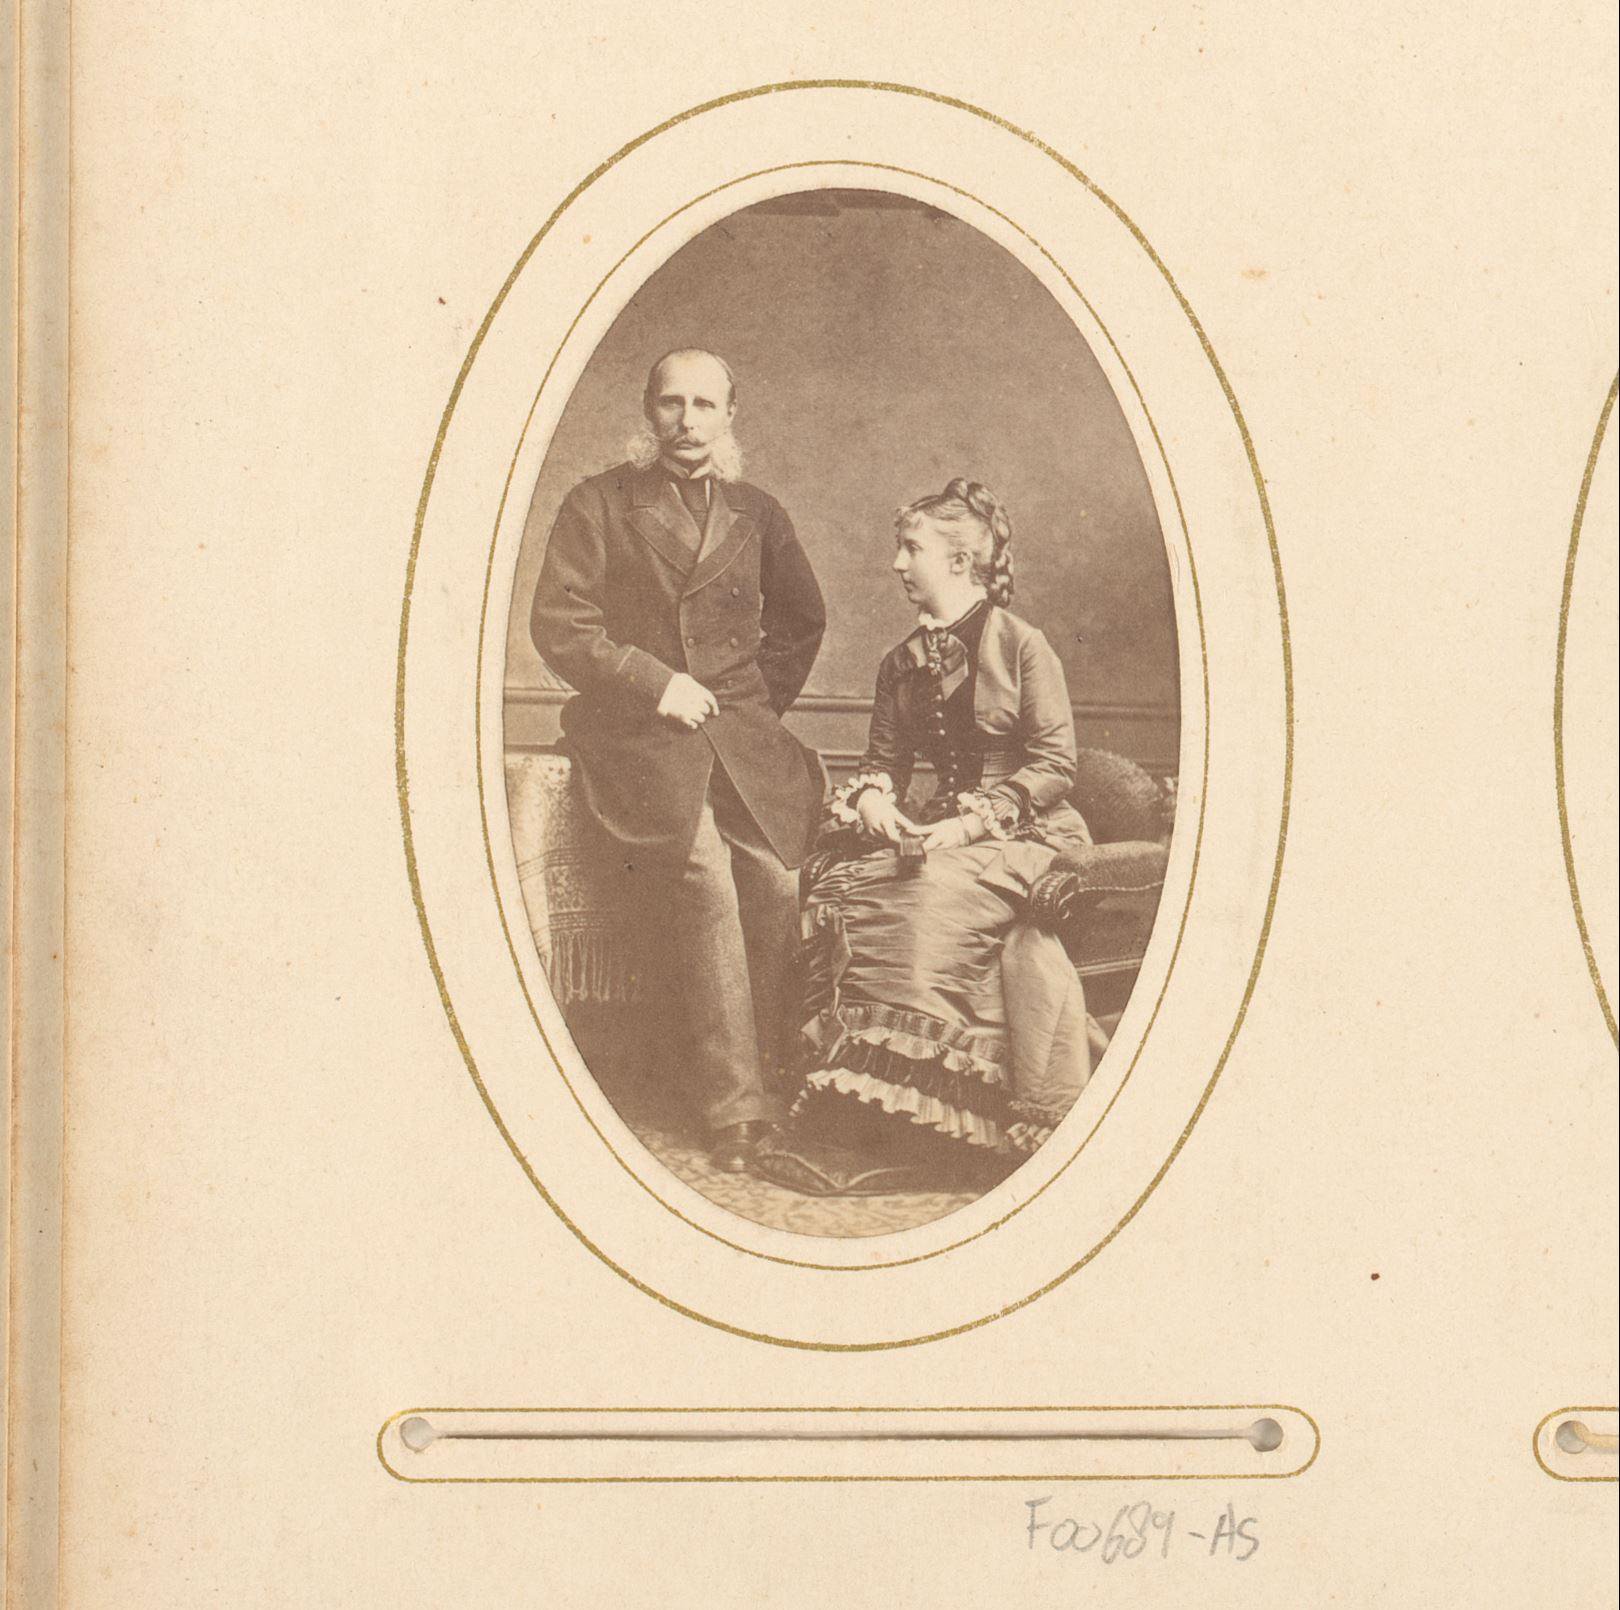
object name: album leaf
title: Portret van echtpaar Hendrik van Oranje-Nassau en Maria Elisabeth Louise Frederika van Pruisen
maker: Anonymous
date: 1878-1879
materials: cardboard, photographic support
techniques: albumen print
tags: hendrik (prins der nederlanden), historical persons - bb - woman, historical persons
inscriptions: retailer's mark: ‘papierhandel/ J. Meeussen & zoon/ Korte Poten 32/ Den Haag’